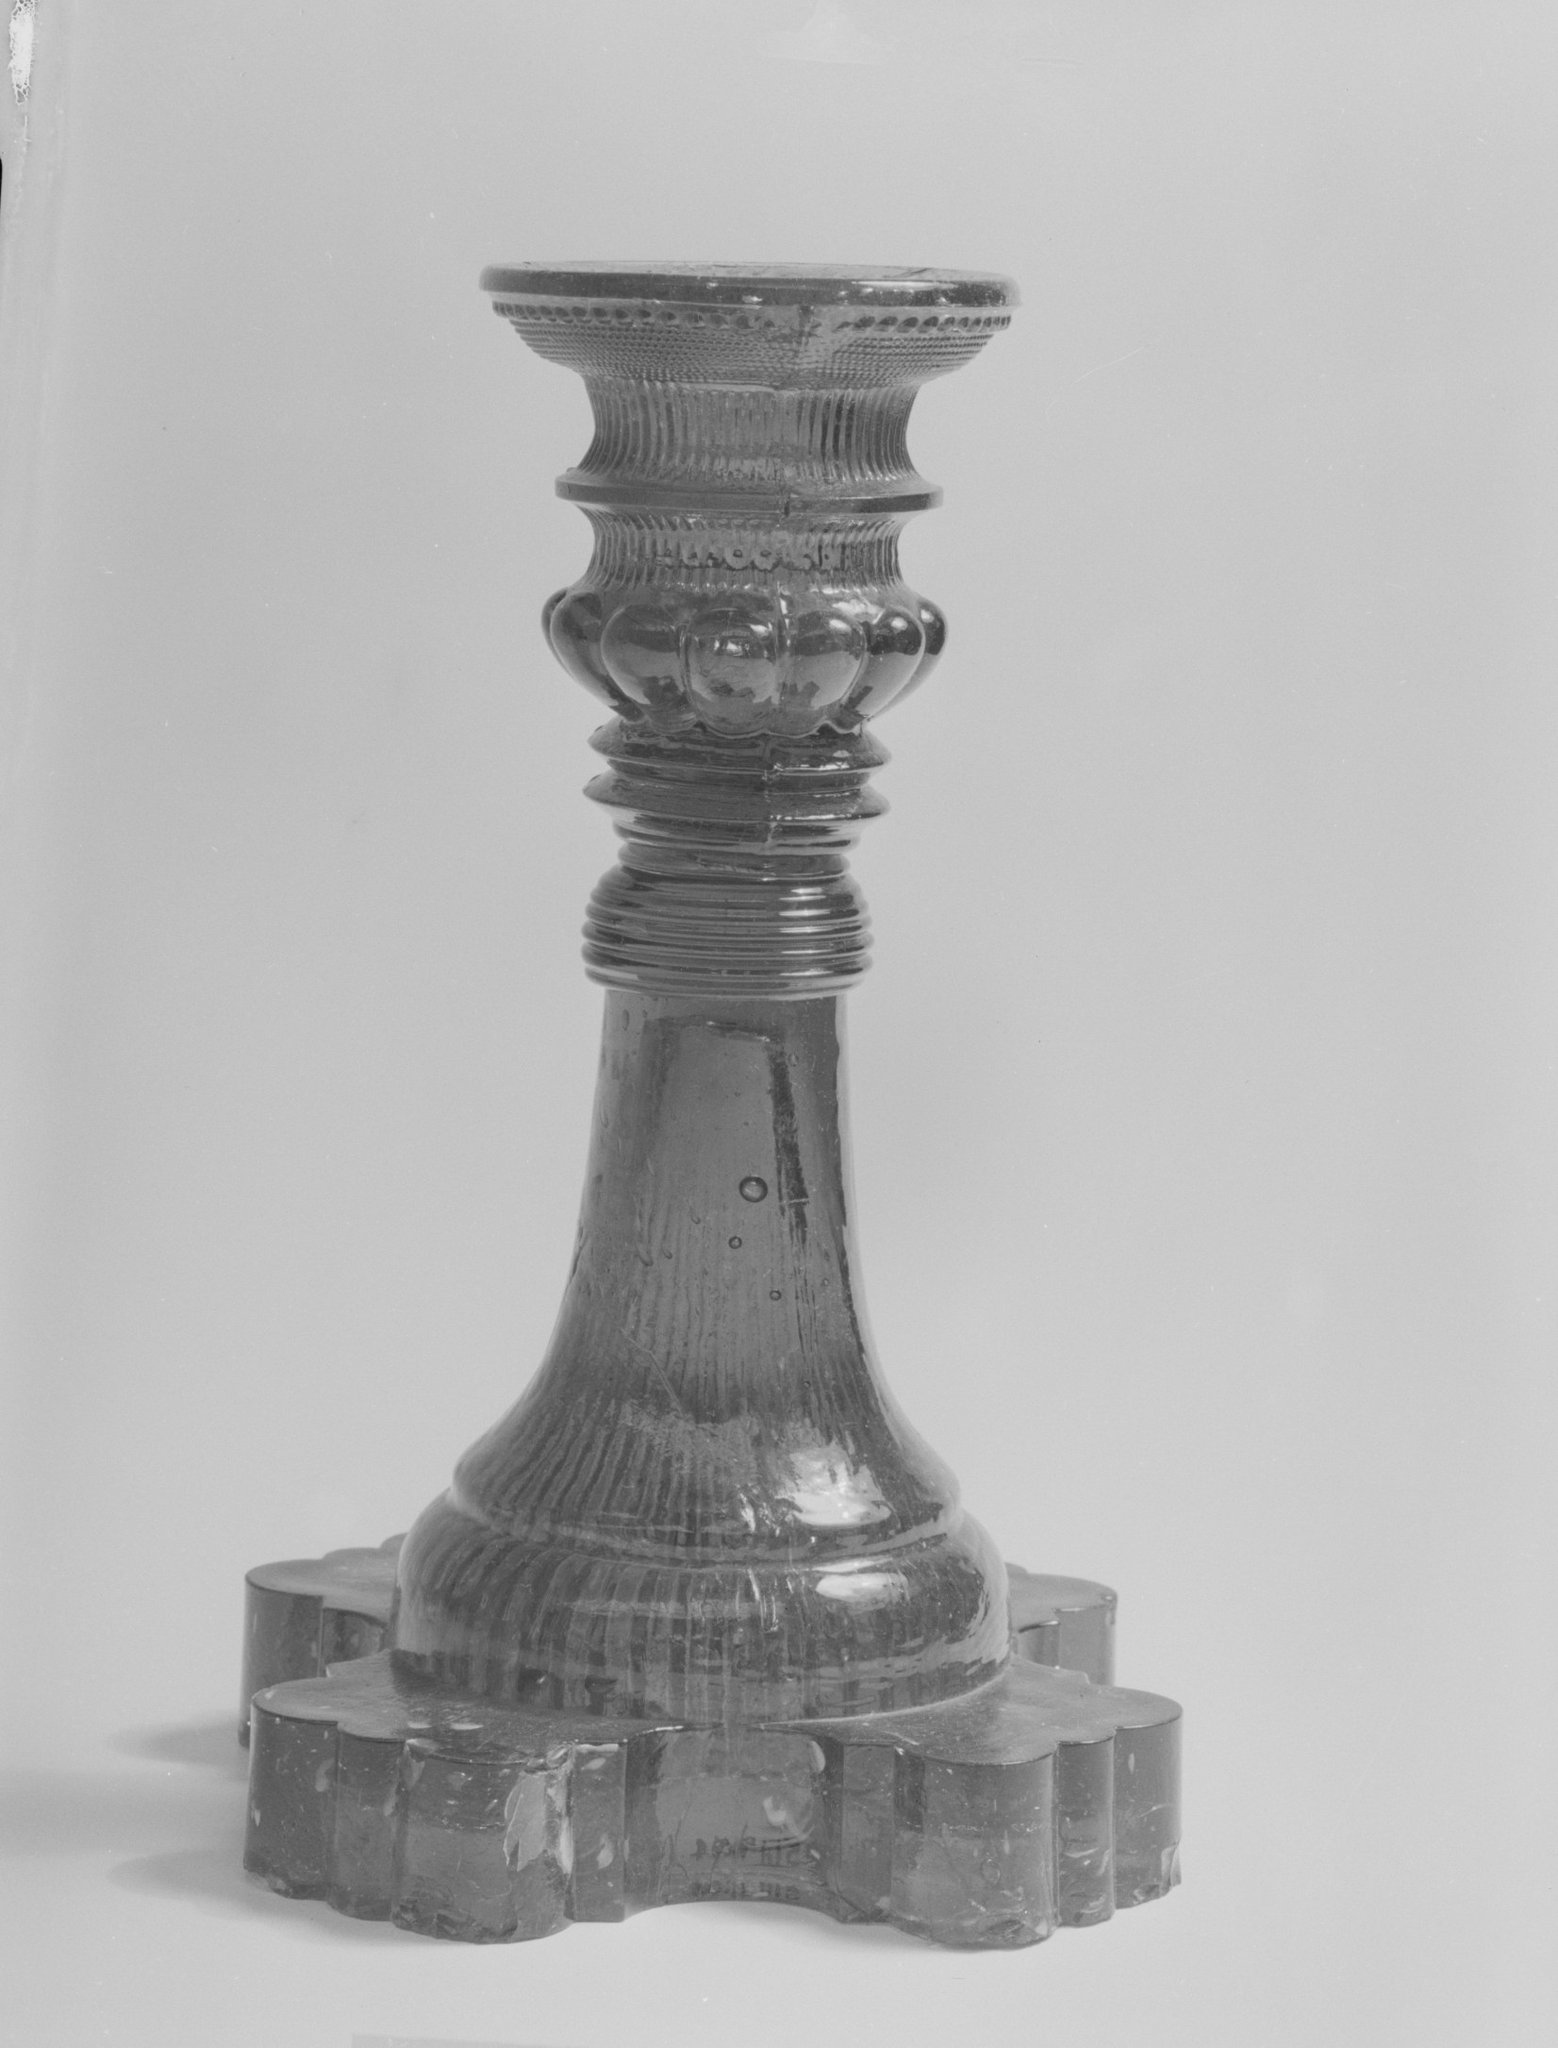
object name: candlestick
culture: american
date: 1830-1900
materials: glass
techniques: pressed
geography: united states